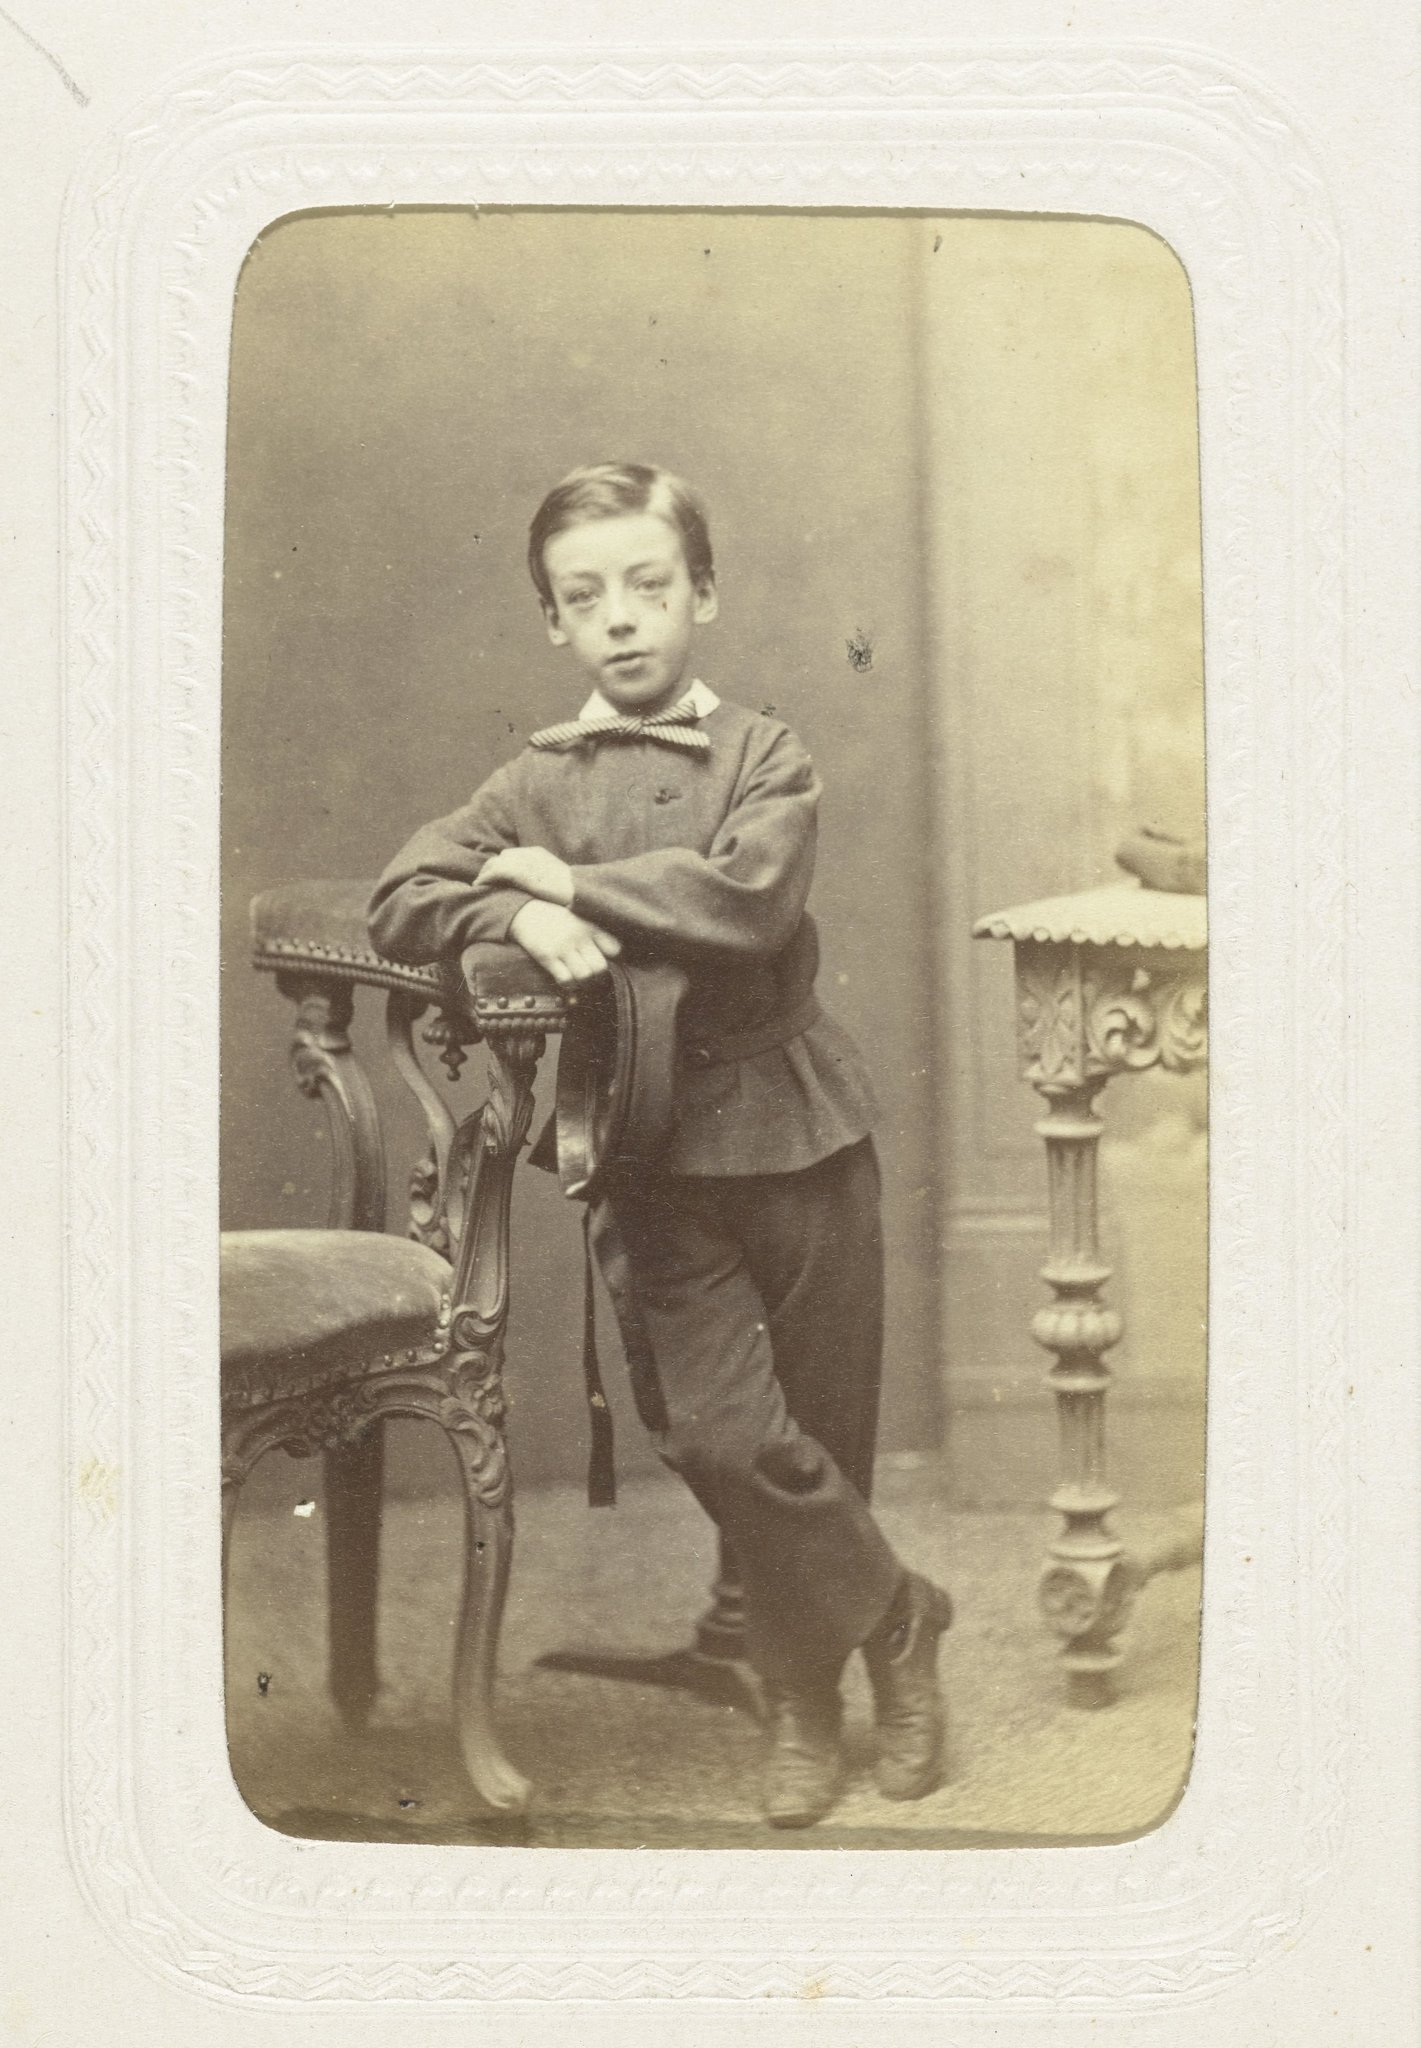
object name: carte de visite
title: Studioportret van een jongen in pak met een grote strik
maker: albert greiner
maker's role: fotograaf, fotostudio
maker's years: 1833-1890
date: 1863-1866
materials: cardboard, paper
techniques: albumen print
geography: amsterdam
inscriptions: name: ‘Albert Greiner, Amsterdam’